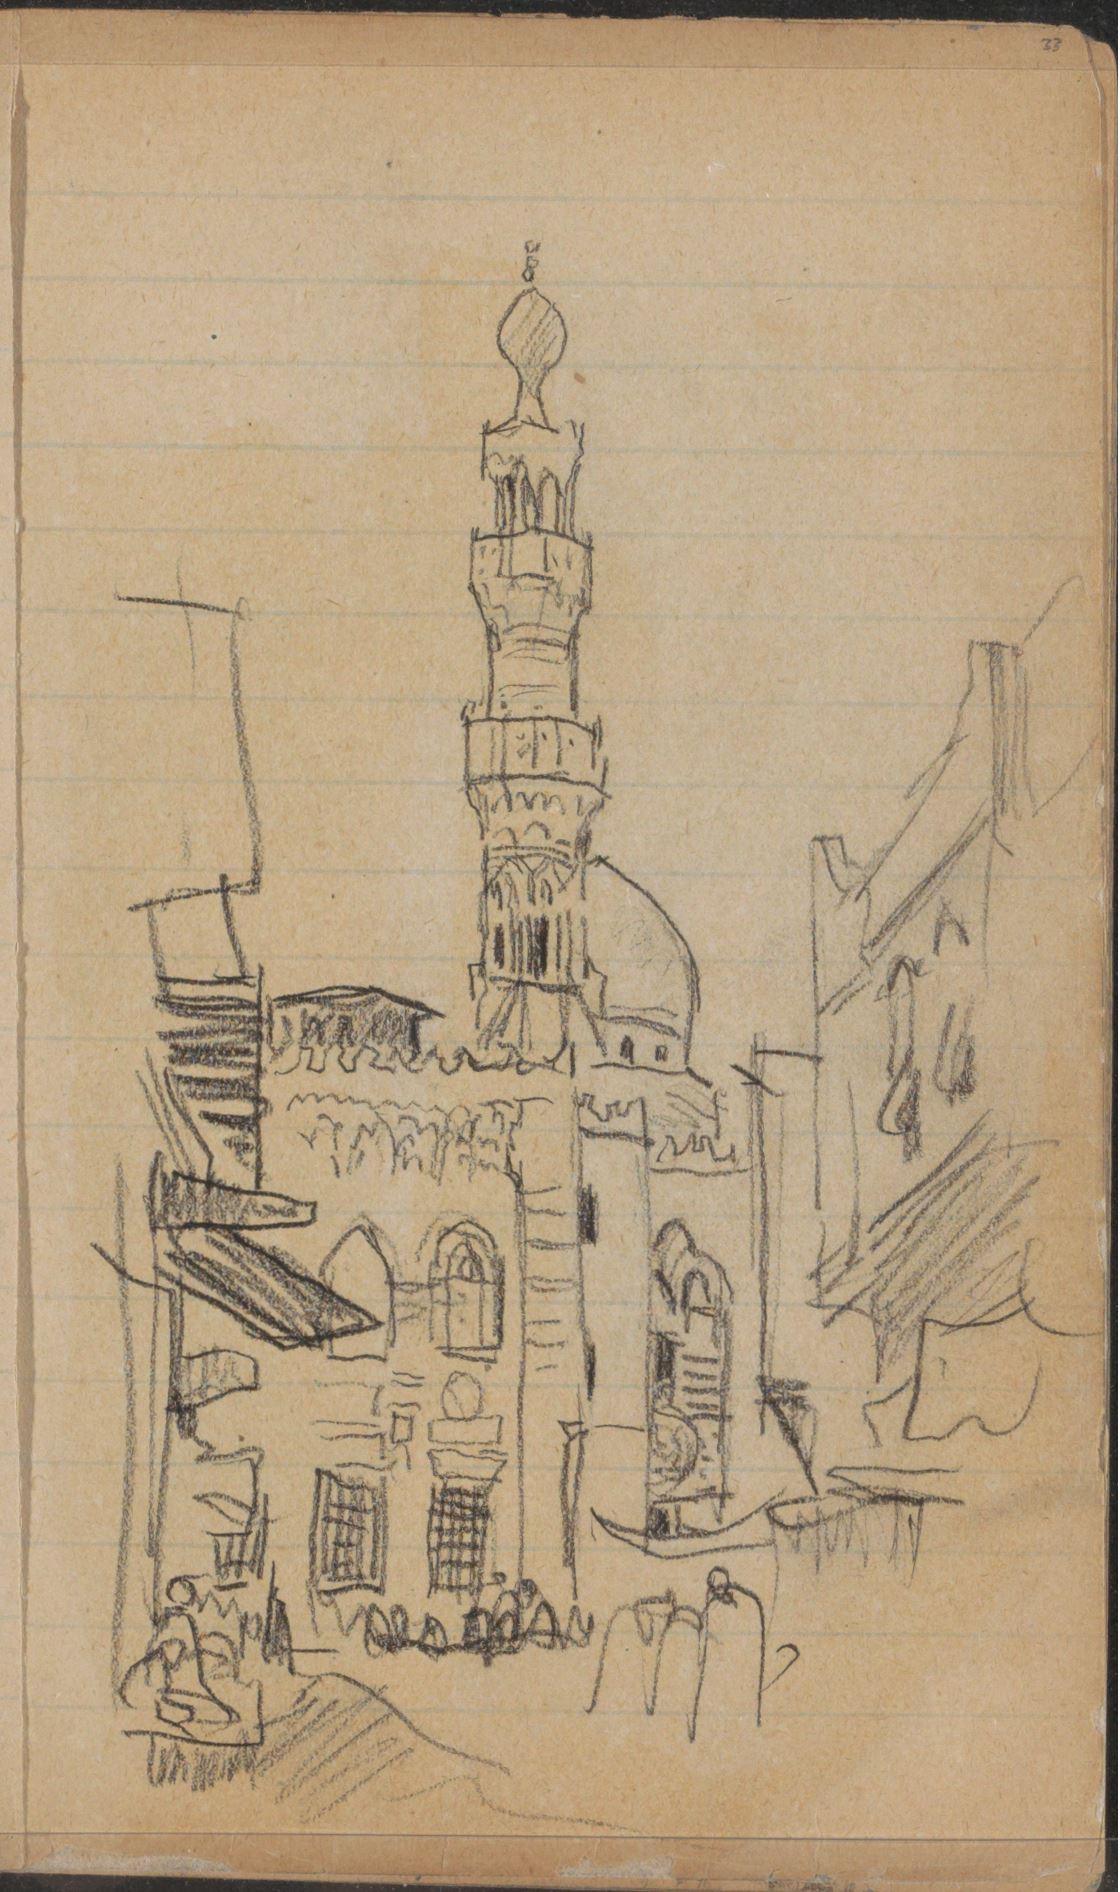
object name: sketchbook leaf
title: Straat in Caïro met uitzicht op de Kait Bey moskee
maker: marius bauer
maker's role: draughtsman, print maker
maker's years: 1867-1932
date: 1894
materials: chalk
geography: cairo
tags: temple, shrine ~ islam, mohammedanism, street (+ city(-scape) with figures, staffage)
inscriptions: kleurnotitie, handgeschreven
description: Pagina 33 uit een schetsboek met 48 bladen.